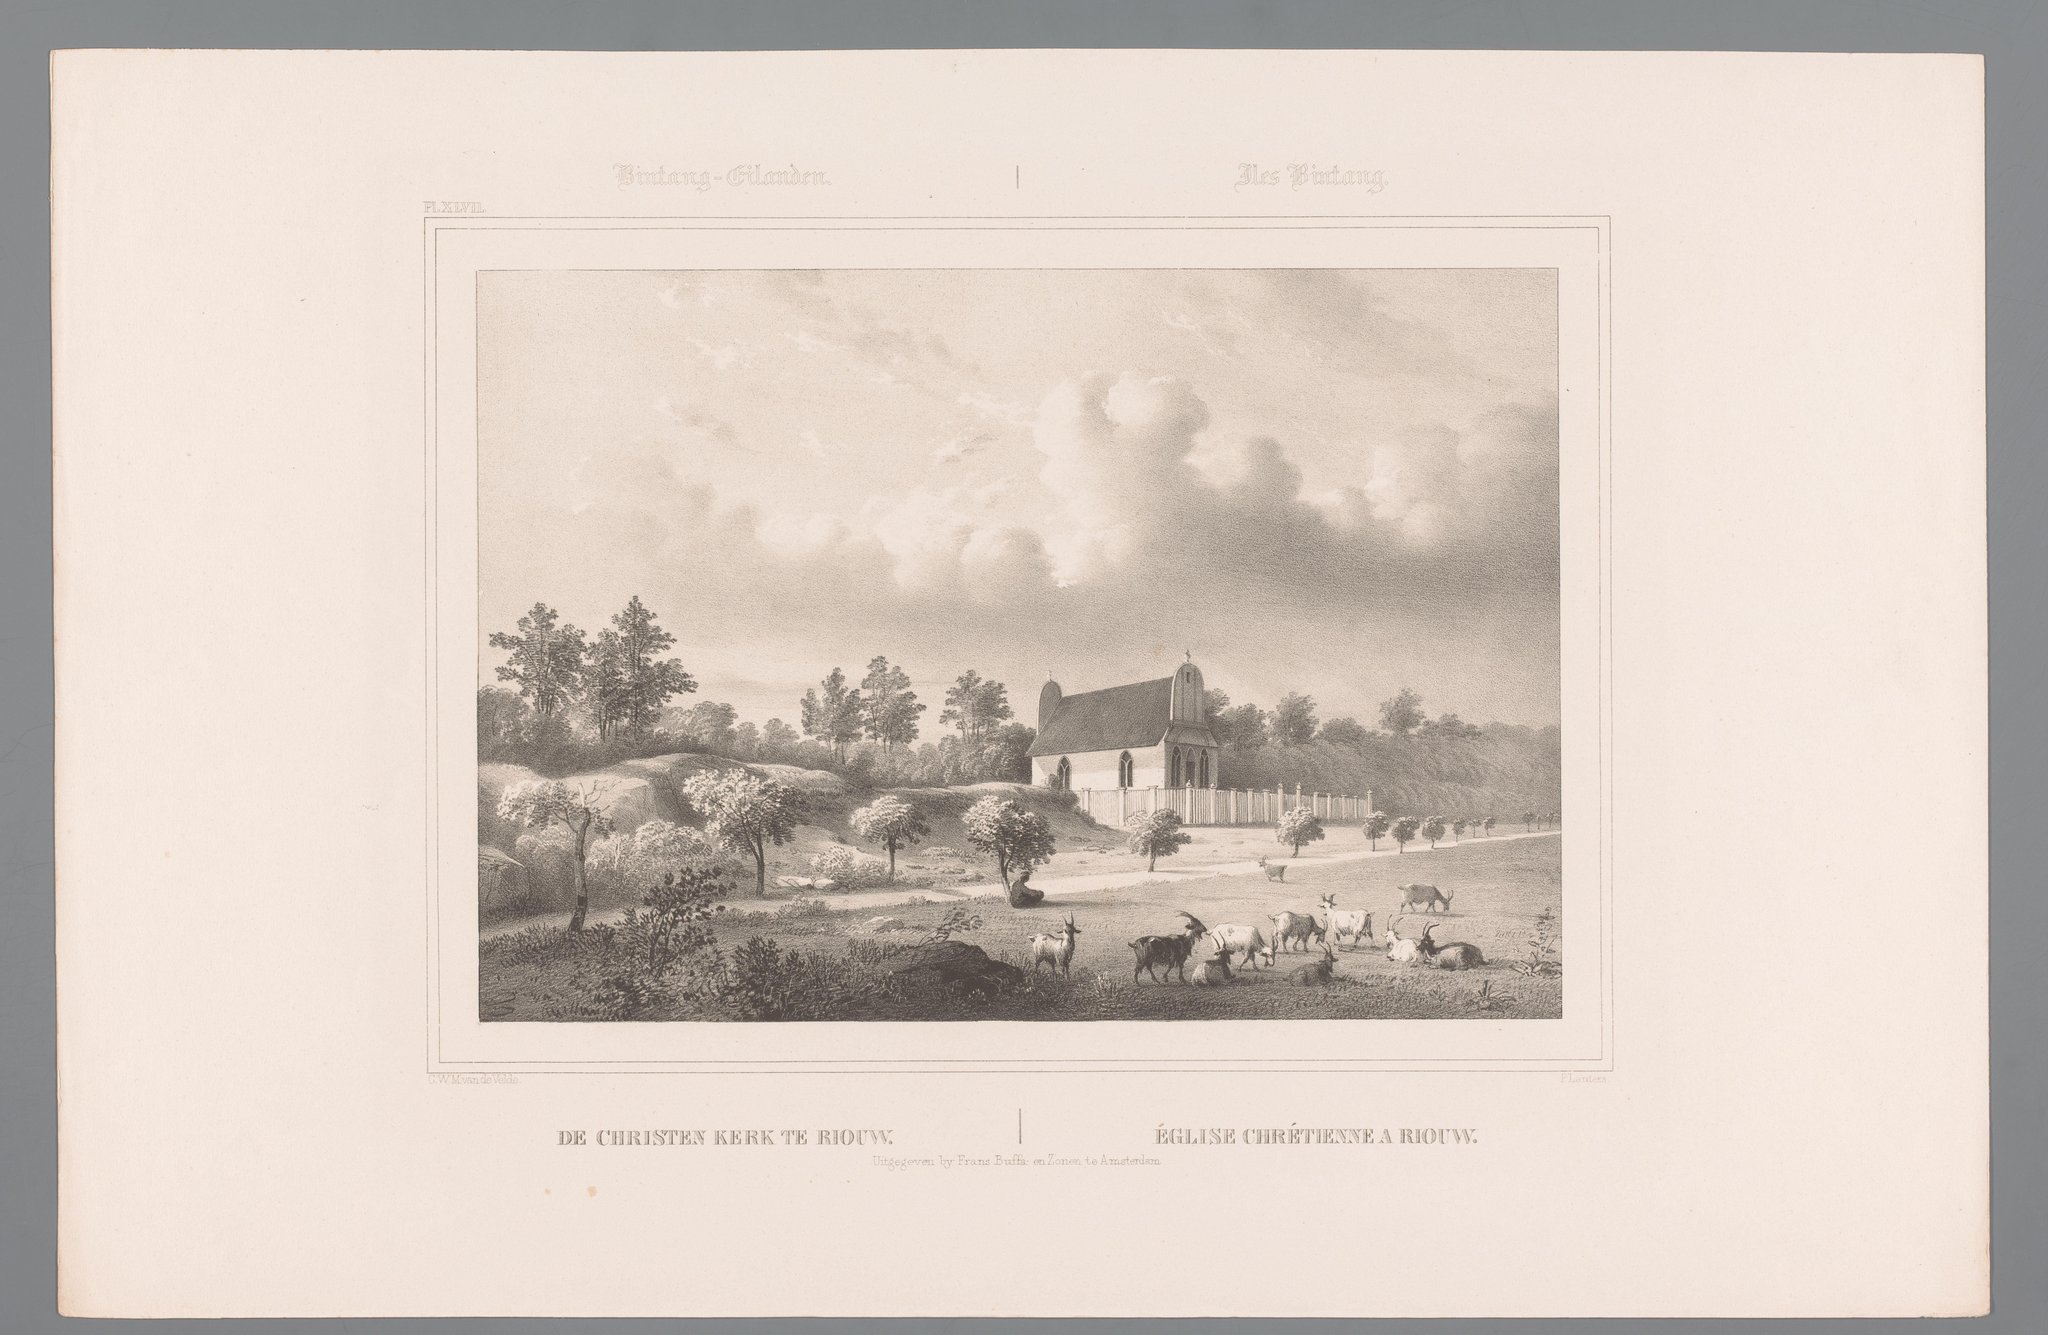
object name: print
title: Gezicht op een christelijke kerk te Riauw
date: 1847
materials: paper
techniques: lithograph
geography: amsterdam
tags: herding, herdsman, herdswoman, shepherd, shepherdess, cowherd, etc., church (exterior), goat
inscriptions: collector's mark: Lugt 2228